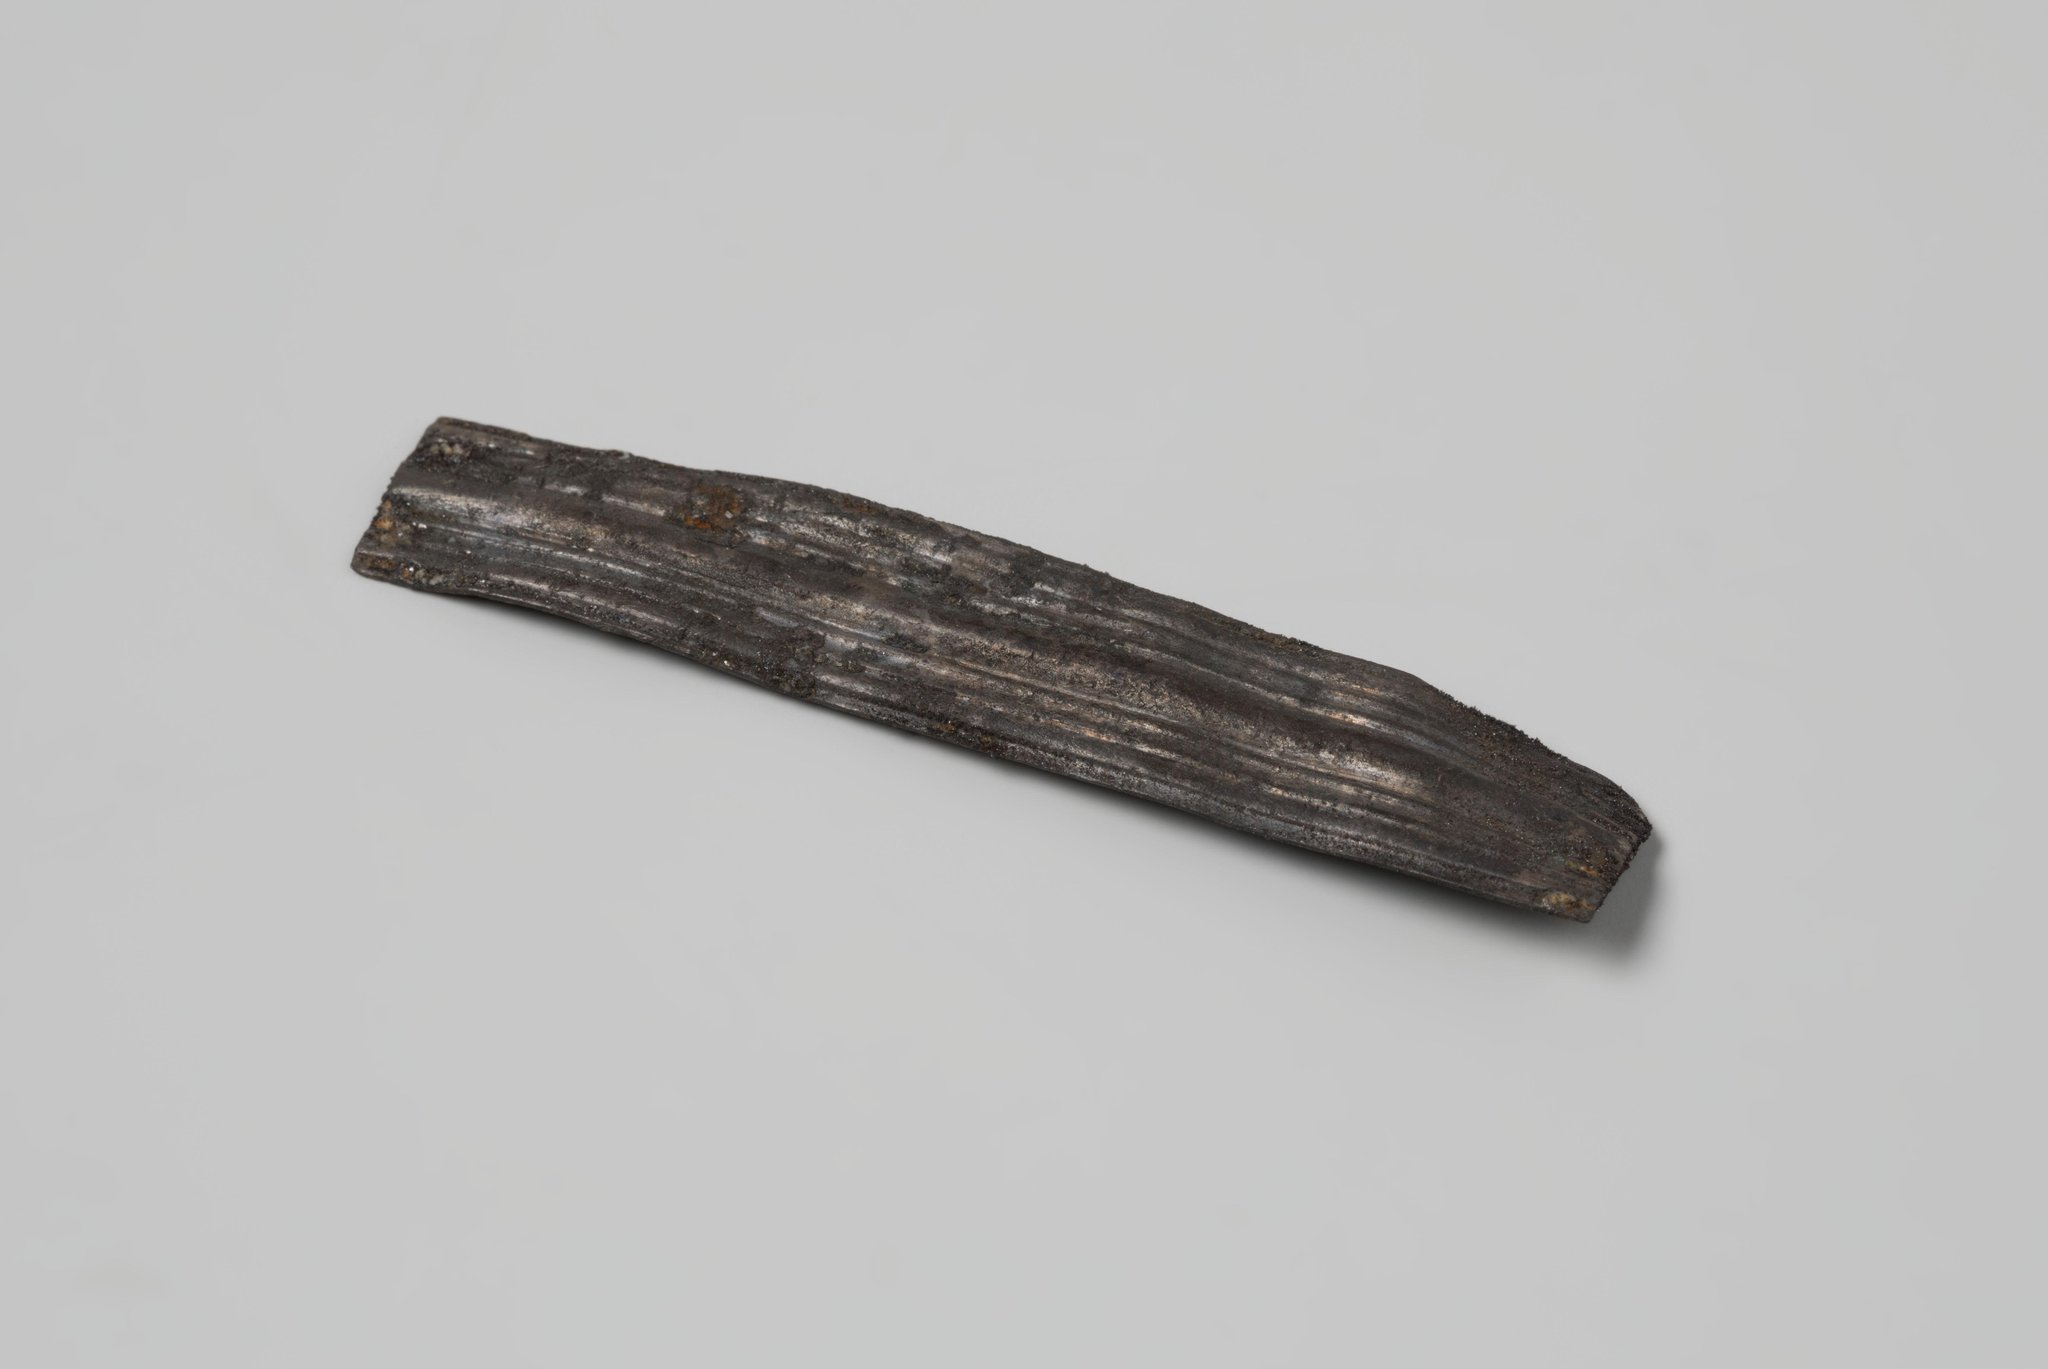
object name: beslag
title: Decoratief beslag uit het wrak van de Oost-Indiëvaarder Hollandia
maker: Anonymous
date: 1700-1743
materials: silver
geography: netherlands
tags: verenigde oostindische compagnie, hollandia (schip), annet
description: Fitting, decorative fitting or fragment; strip, flat, straight, relieved multiple-reeded pattern.